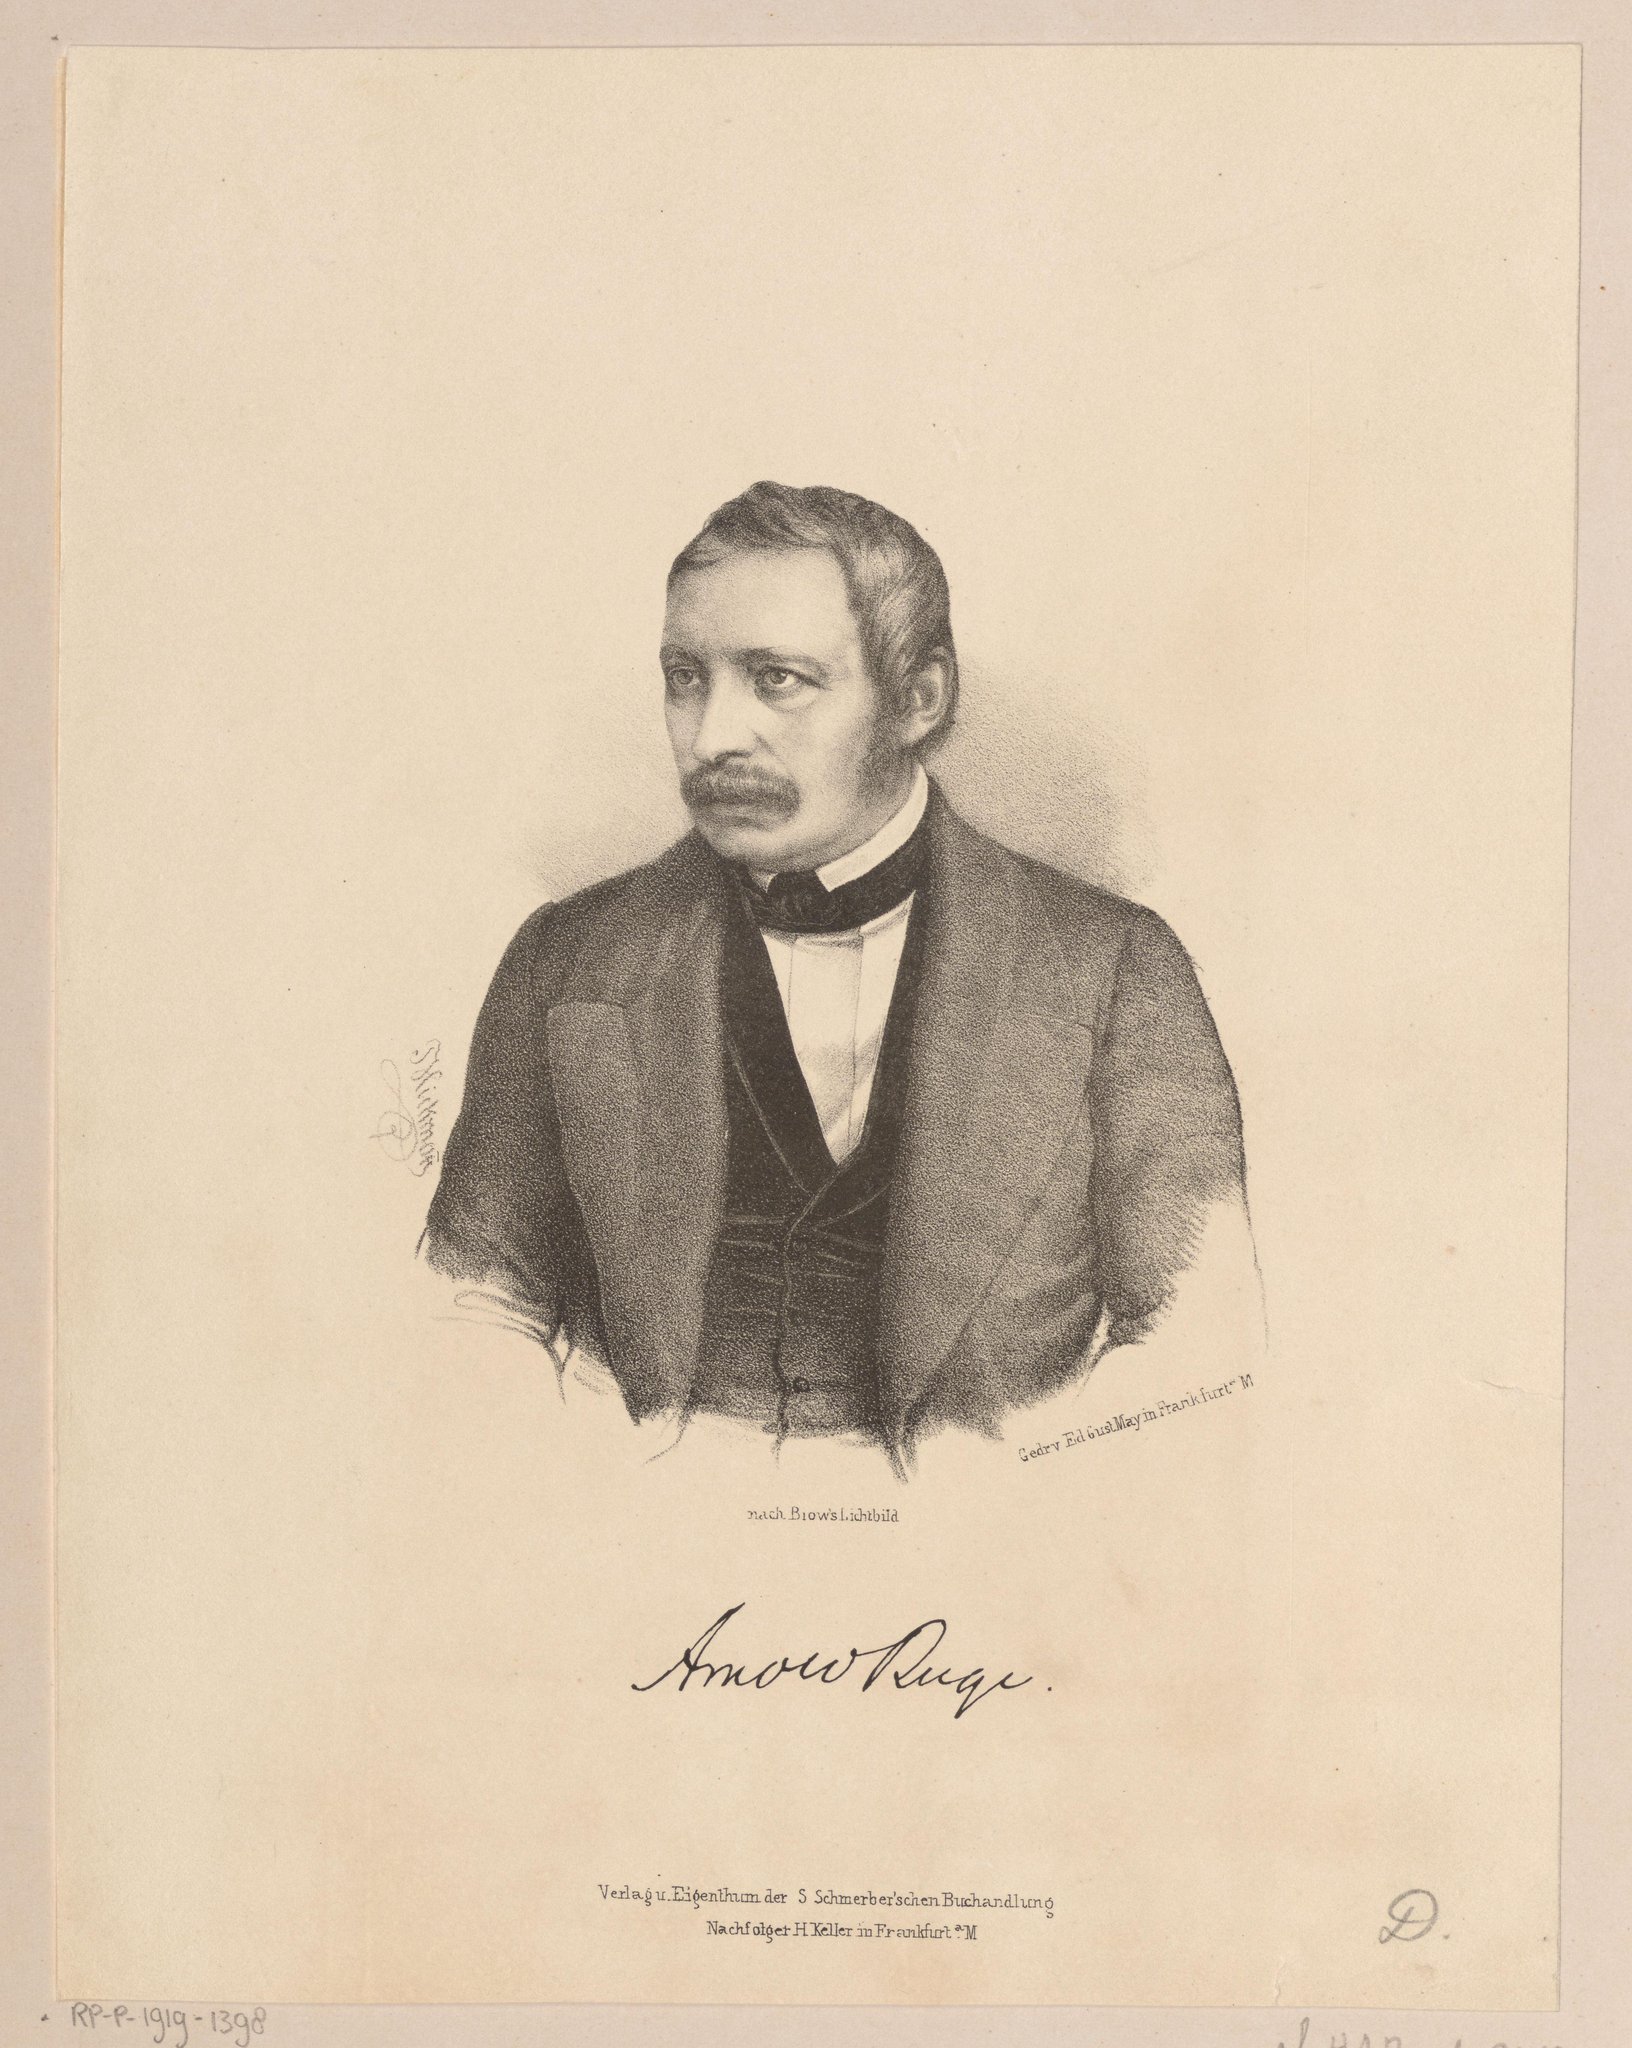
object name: print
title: Portret van Arnold Ruge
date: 1845-1884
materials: paper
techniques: lithograph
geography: frankfurt am main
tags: historical persons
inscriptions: collector's mark: Lugt 2228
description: Onder het portret een facsimile van de handtekening van de geportretteerde.